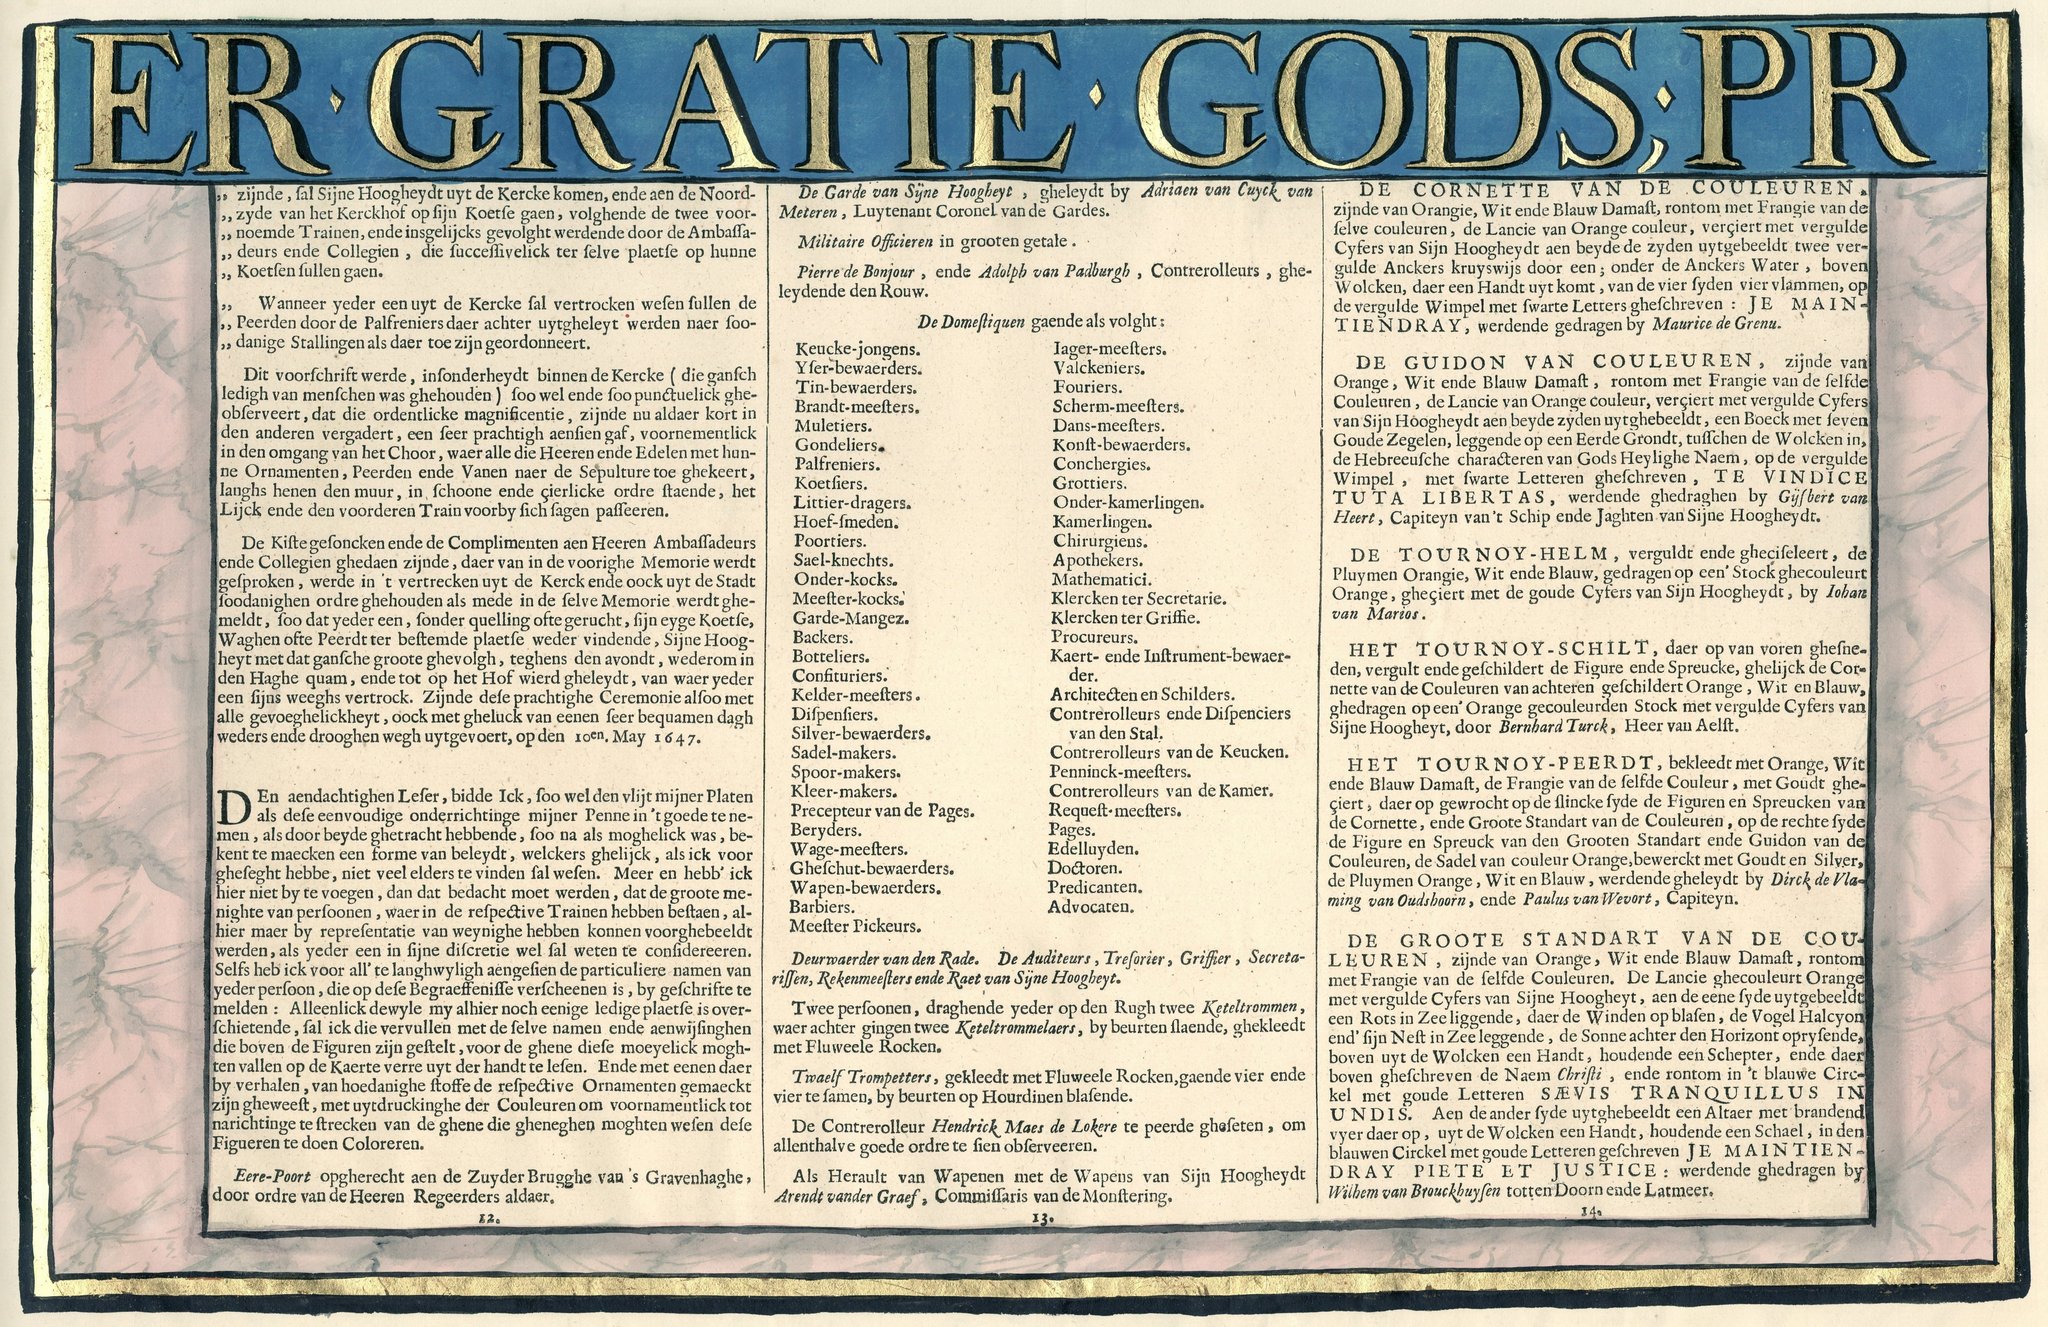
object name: programma, programmaboekje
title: Programma van de begrafenis van Frederik Hendrik, p. 12-14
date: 1651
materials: paint, paper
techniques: colour, letterpress printing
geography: the hague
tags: delft, frederick henry (prince of orange)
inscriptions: date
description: Pagina's 12-14 van het programma van de begrafenis van Frederik Hendrik. Blad in een gekleurde omlijsting versierd met goud en ingeplakt in de luxe editie uit ca. 1755 van het boek 'Begraeffenisse van syne hoogheyt Frederick Henrick' van Pieter Post, uitgegeven te Amsterdam in 1651.